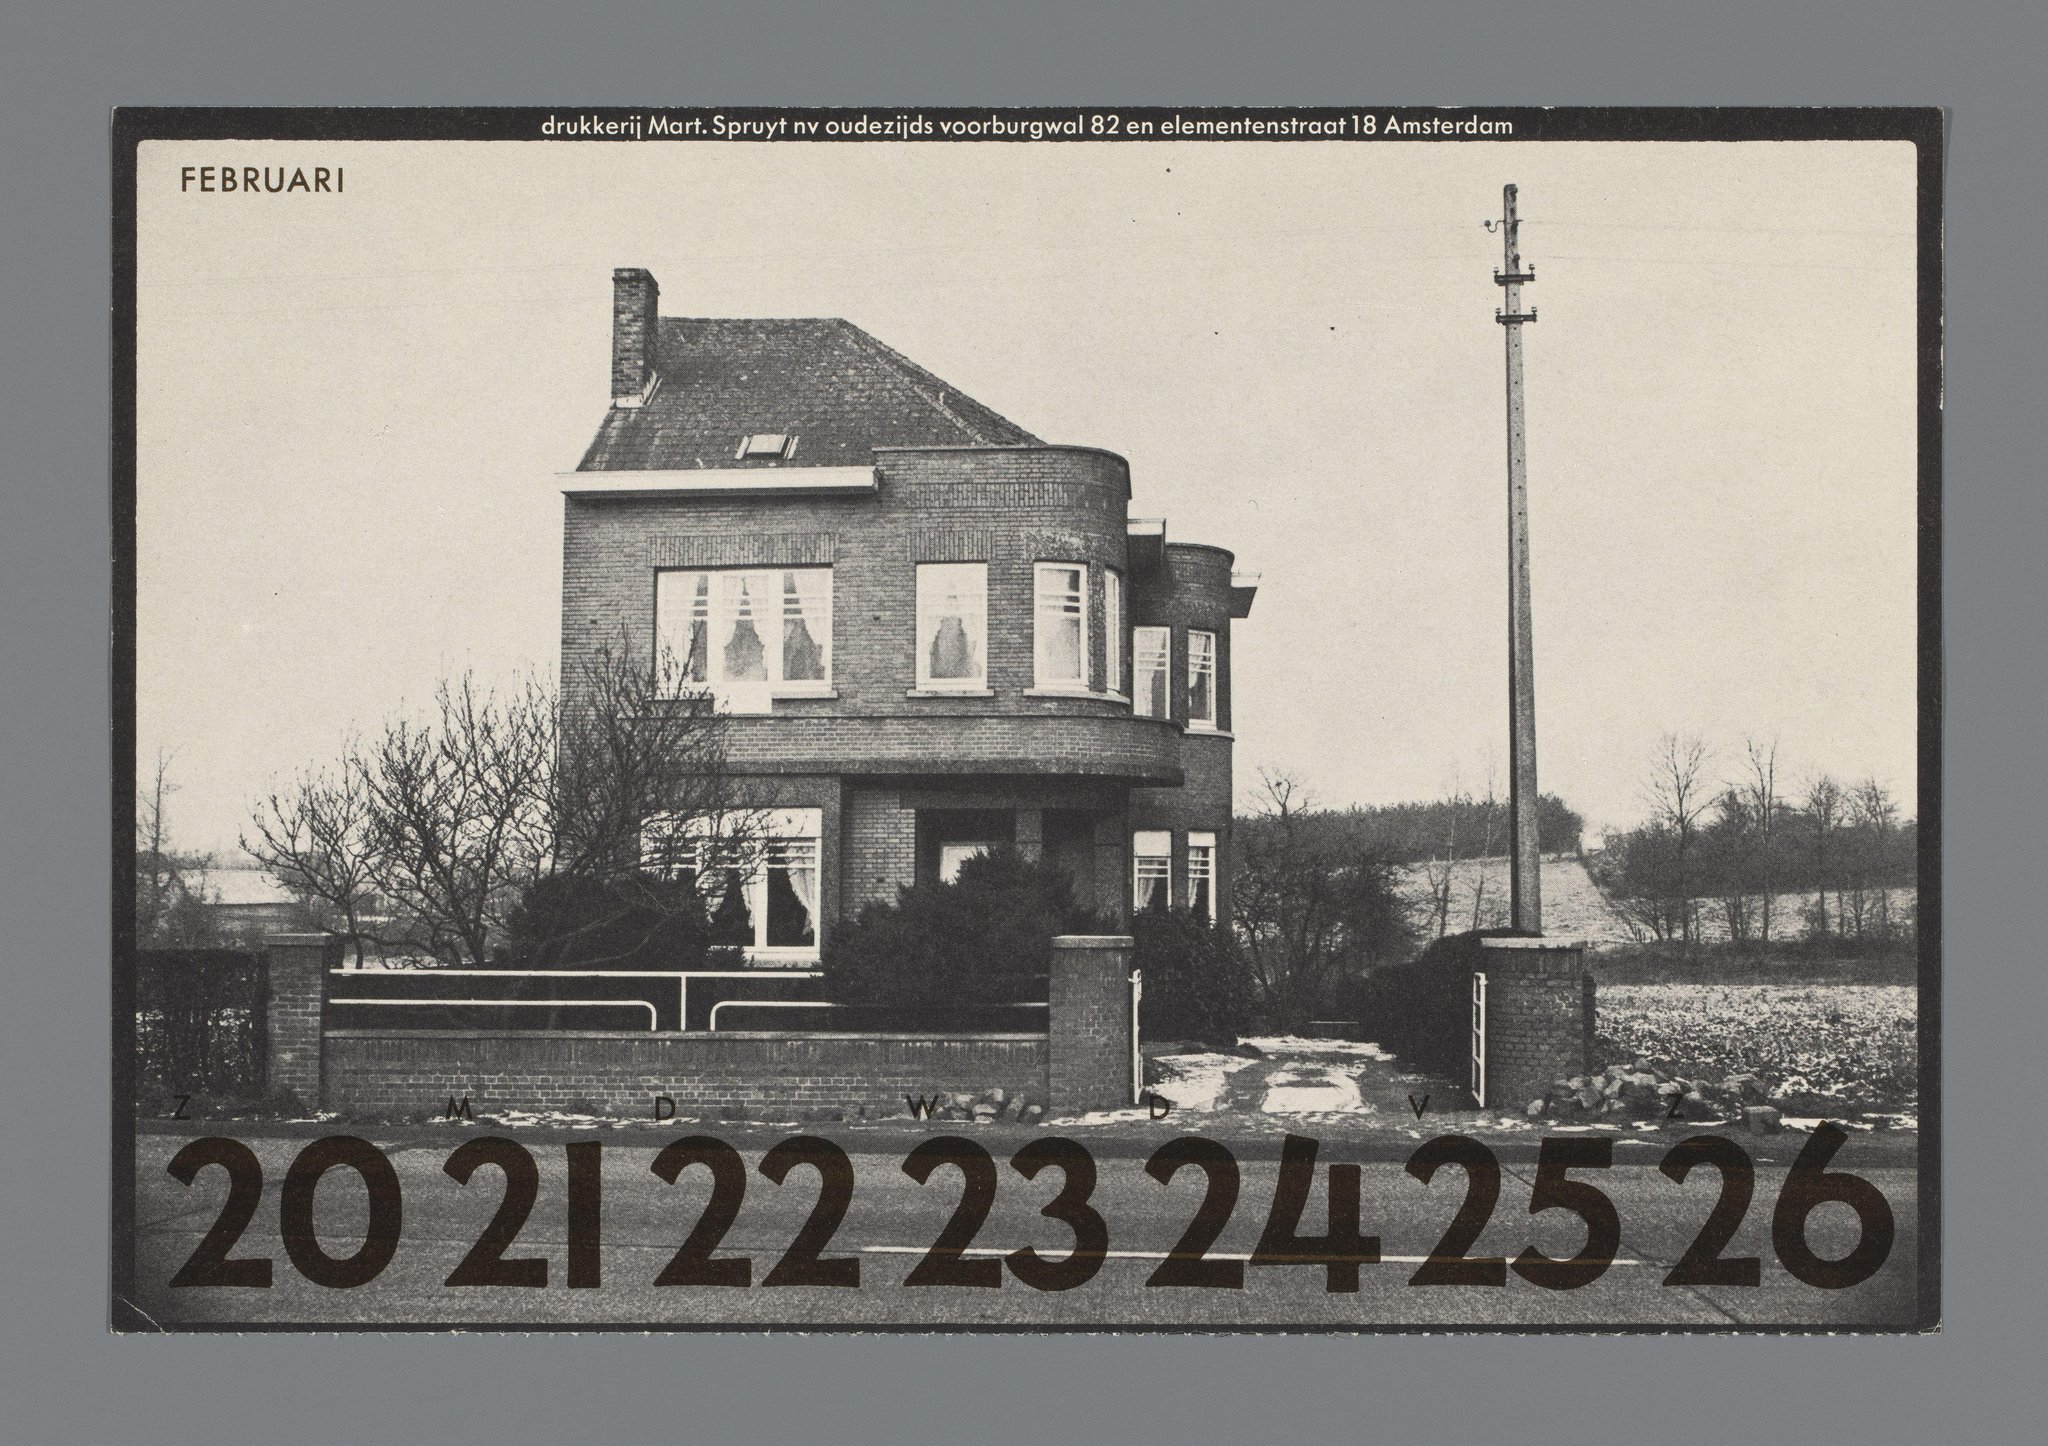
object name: photograph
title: België. Huizen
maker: Anonymous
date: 1900-1950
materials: paper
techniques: offset printed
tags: belgium